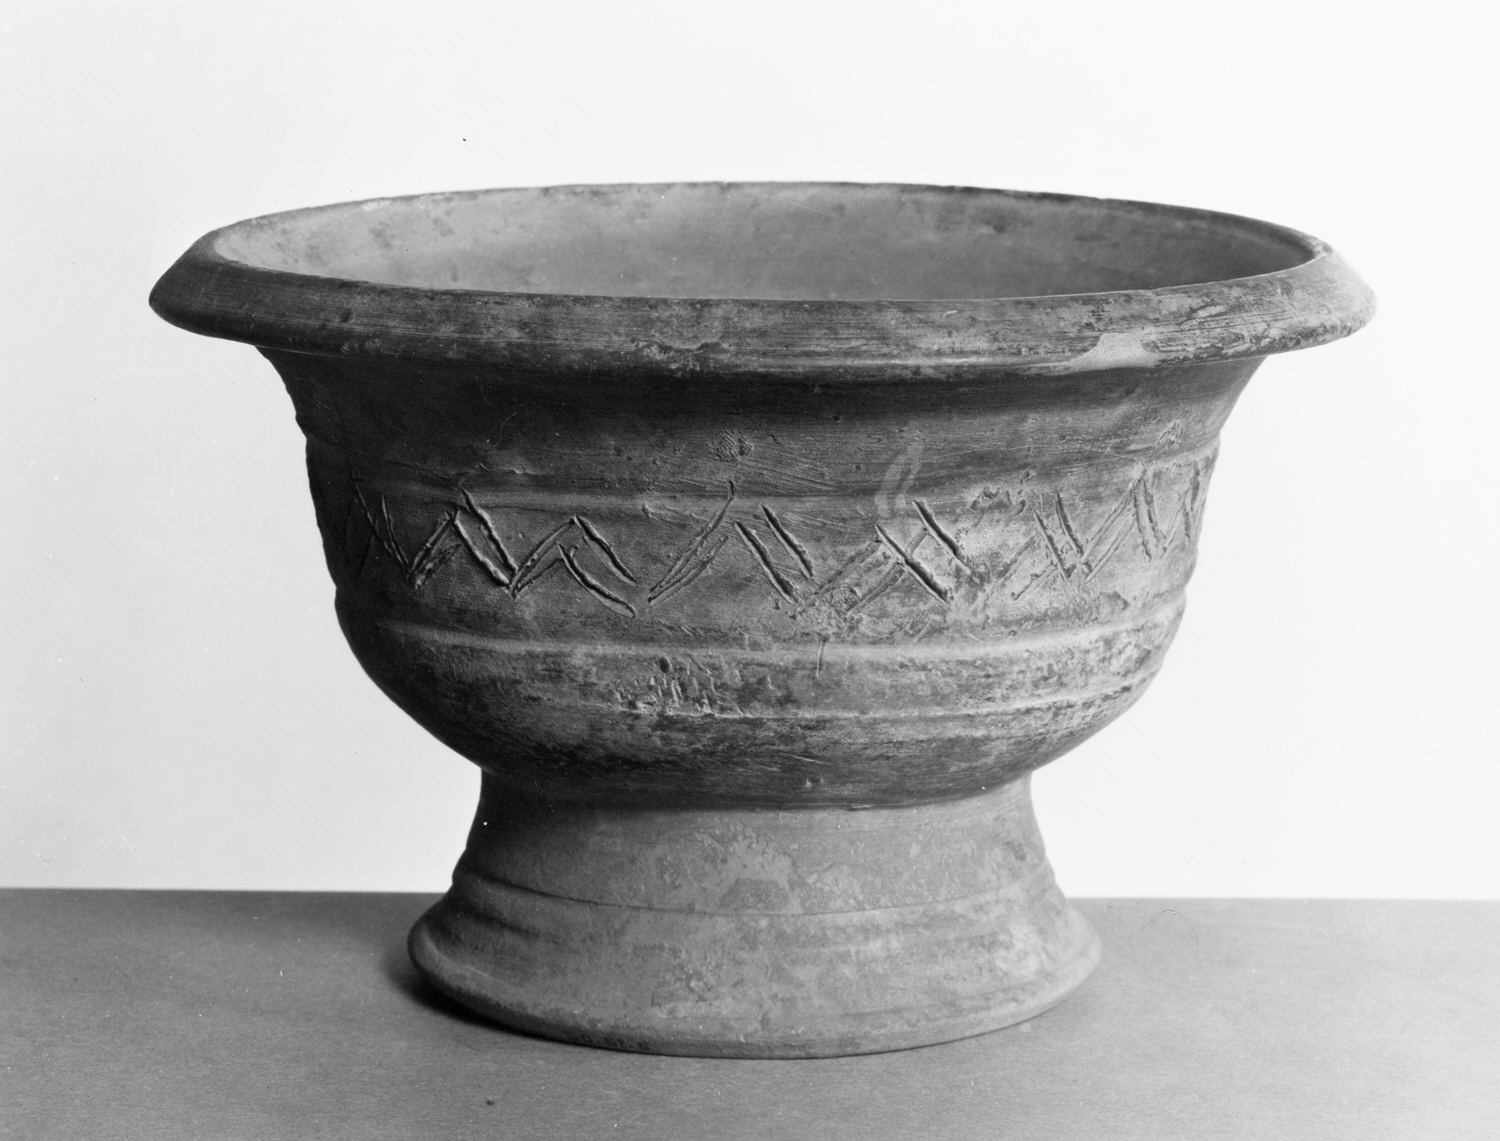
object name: bowl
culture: chinese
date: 1100-901 BCE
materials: earthenware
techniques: carving, incising